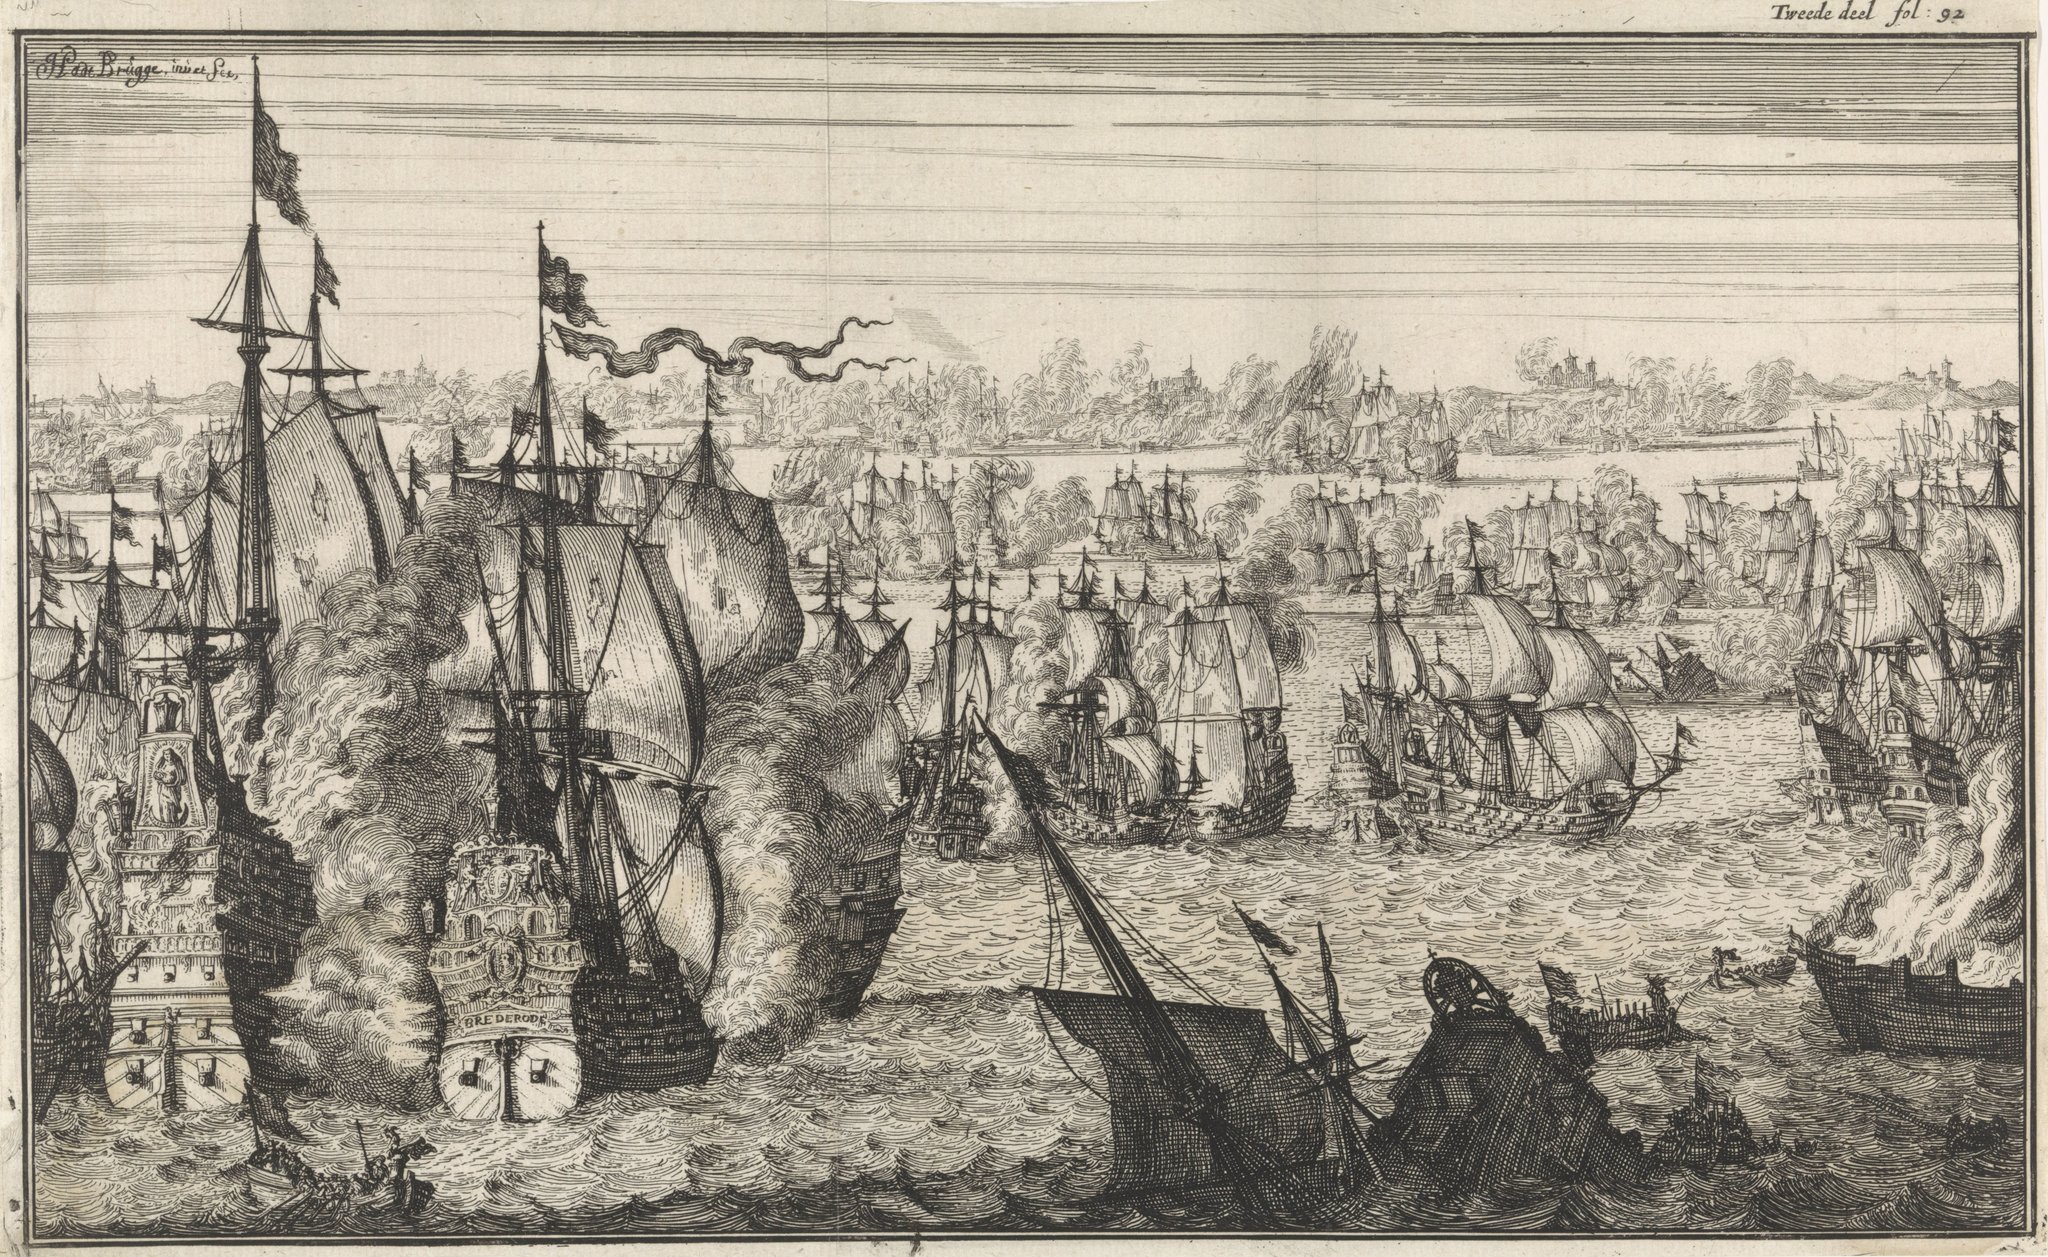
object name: book illustration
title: Zeeslag bij Duins, 1639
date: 1676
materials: paper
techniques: engraving, etching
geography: amsterdam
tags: brielle, maarten harpertszoon tromp, battle (+ naval force), battle of the downs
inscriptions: collector's mark: Lugt 2228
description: De zeeslag bij Duins tussen de Spaanse vloot onder bevel van Antonio de Oquendo en de Staatse vloot onder Maarten Harpertsz. Tromp, 21 oktober 1639. Links de Brederode en de verwoesting van een Spaans schip met op de spiegel Maria met kind staande op de maansikkel. Rechts brandende en zinkende schepen.